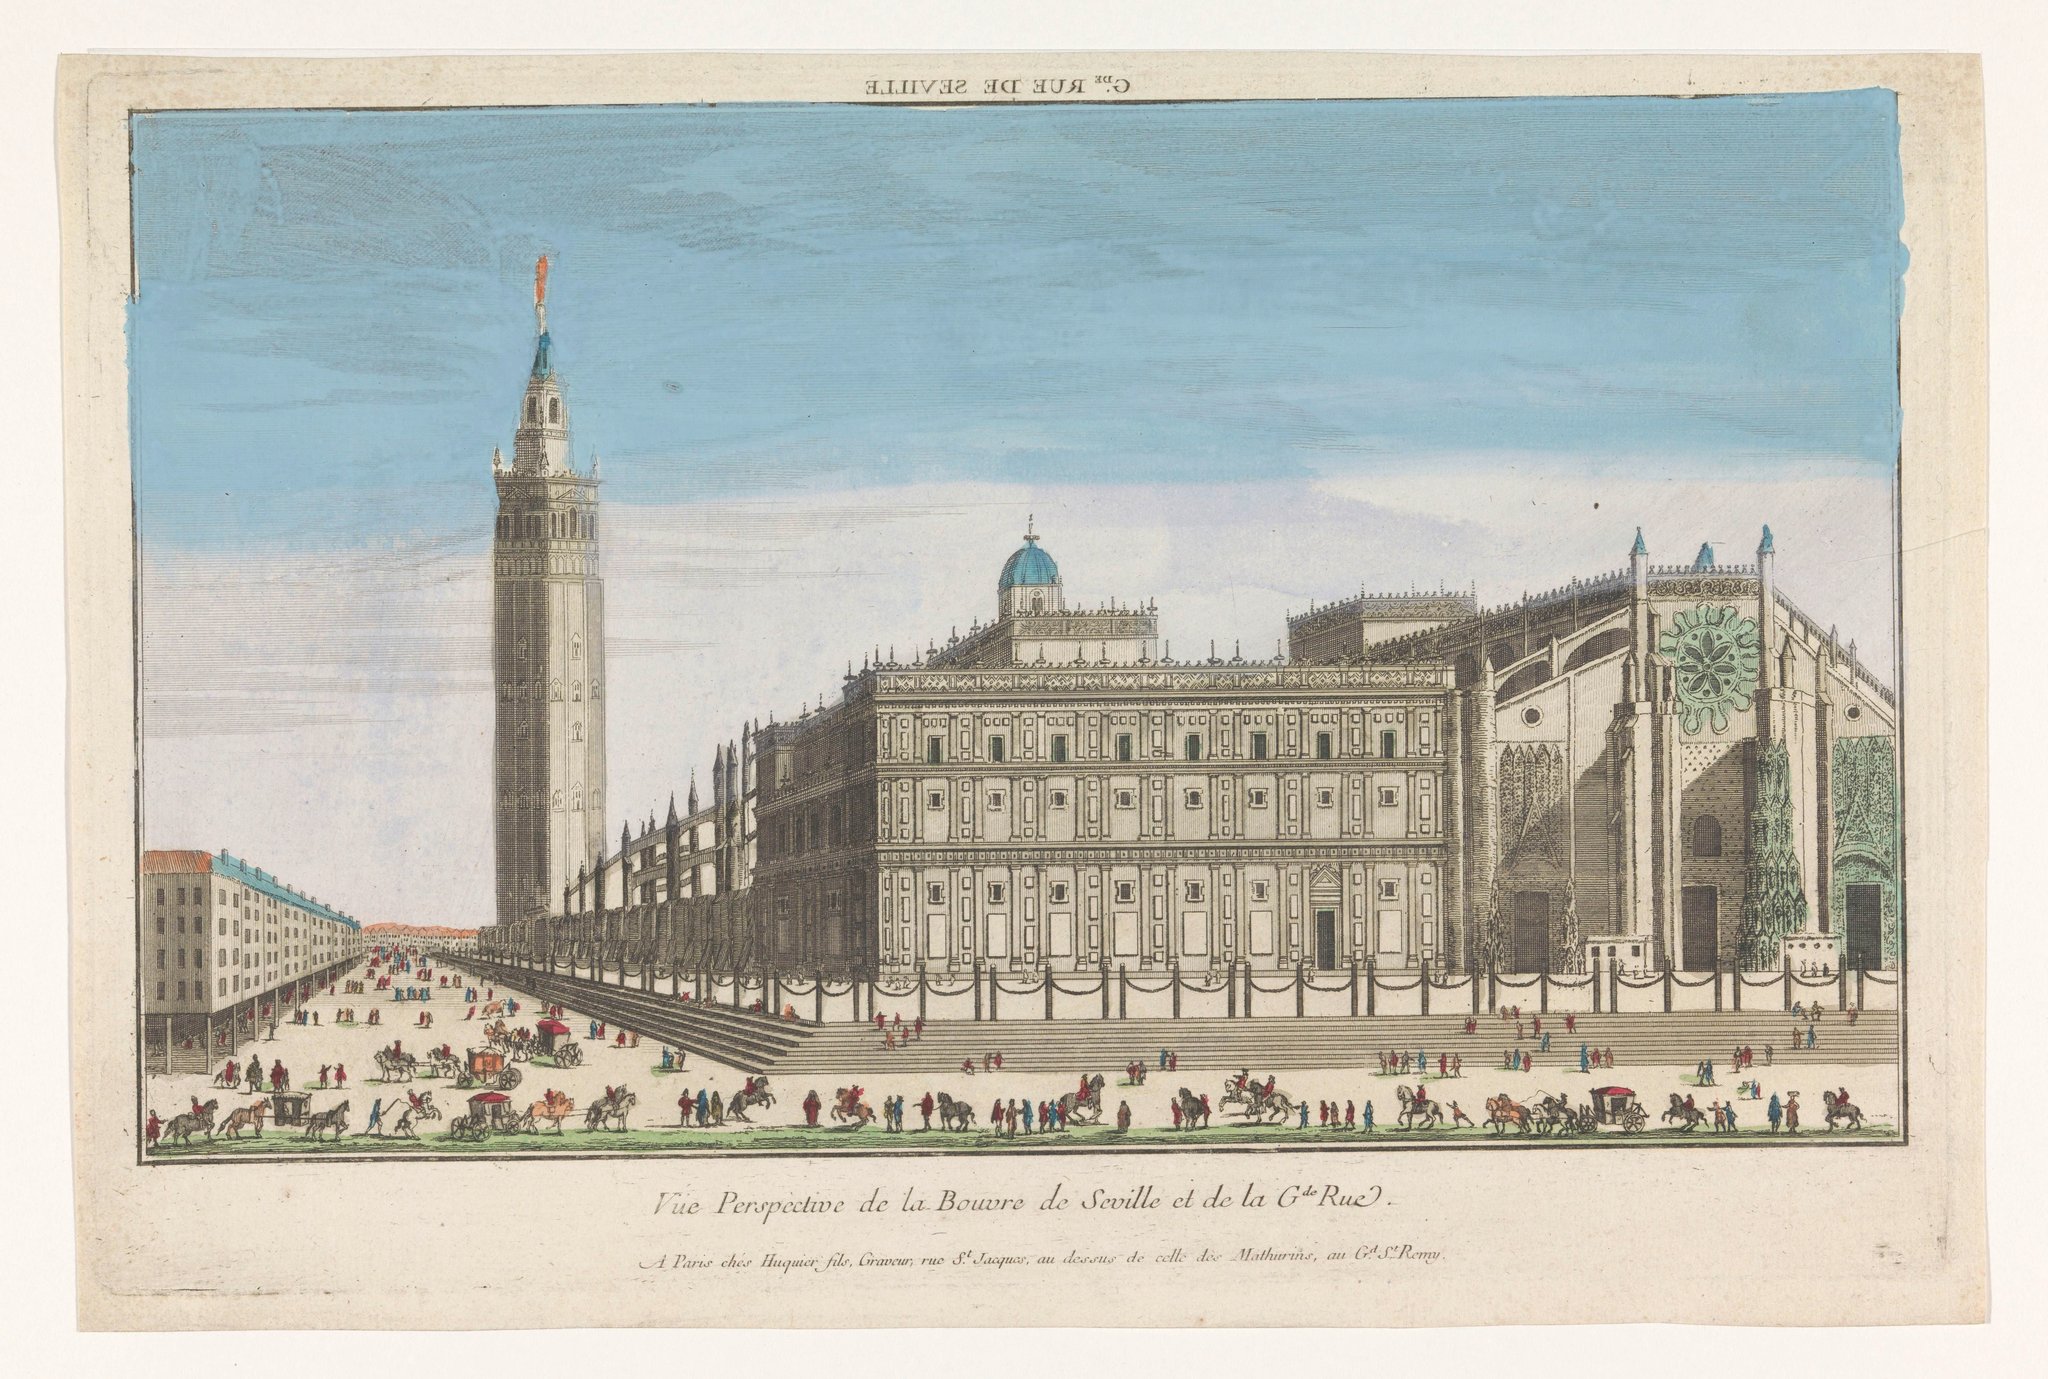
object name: print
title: Gezicht op de Kathedraal van Sevilla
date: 1735-1805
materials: paper, watercolor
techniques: brush, etching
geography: france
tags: stock exchange, stock-market, church (exterior), street (+ city(-scape) with figures, staffage), sevilla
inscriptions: watermark, collector's mark: Lugt 2233